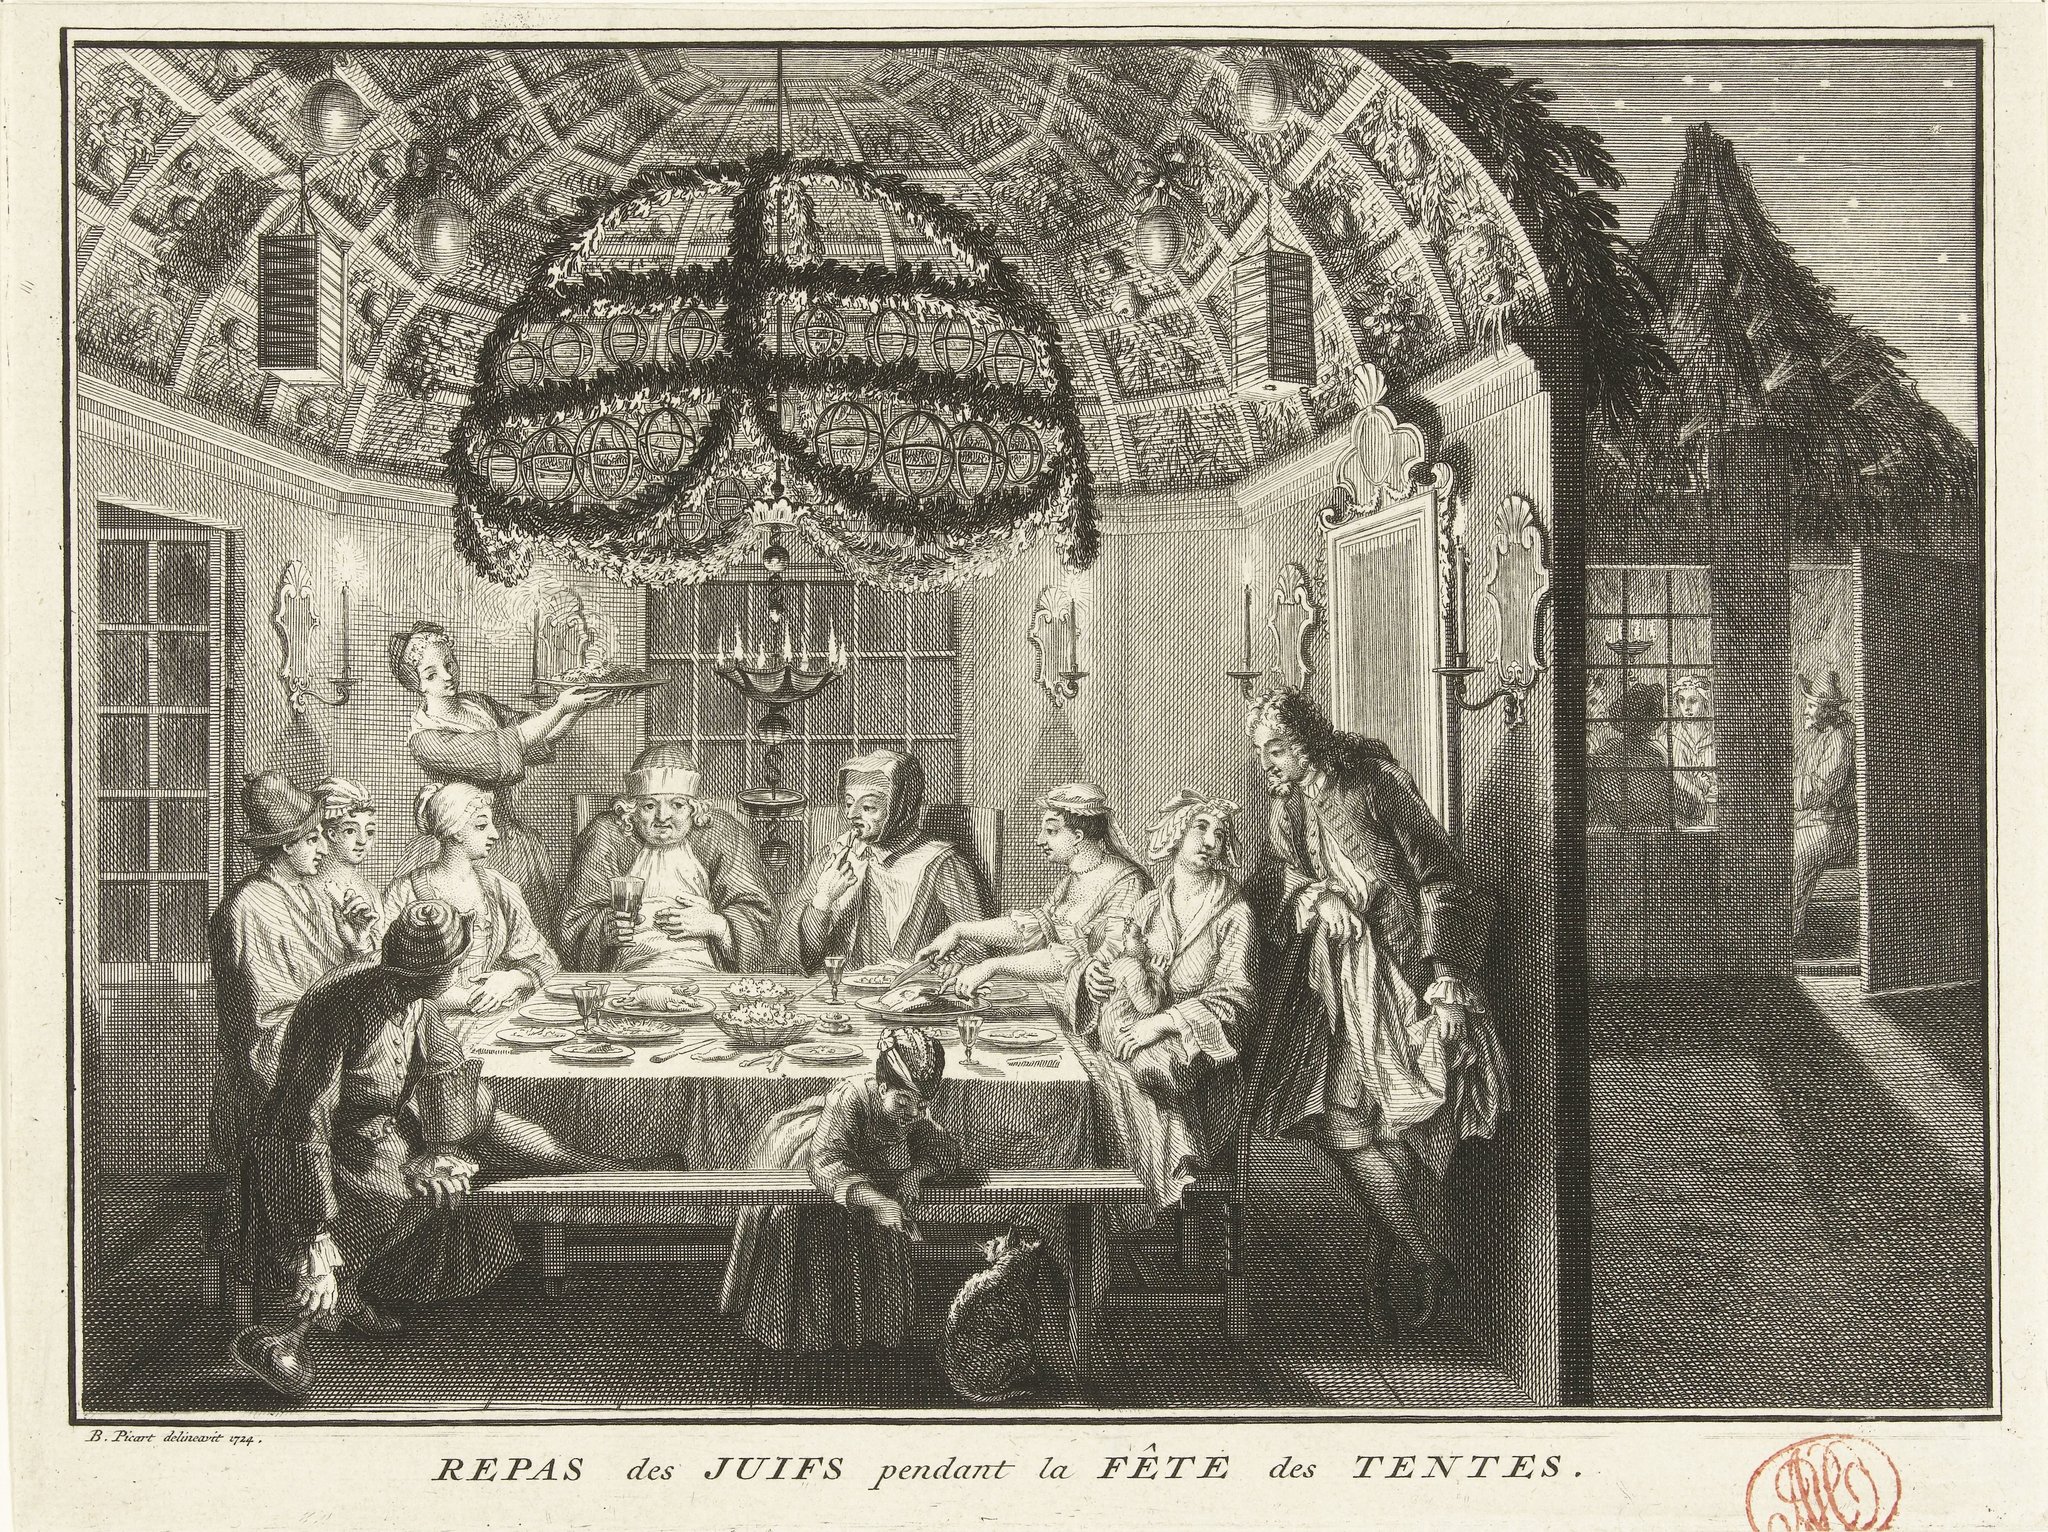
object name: print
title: Repas des Juifs pendant la Fête des Tentes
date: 1724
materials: paper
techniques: engraving, etching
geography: northern netherlands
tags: 'sukkot', feast of the tabernacles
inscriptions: collector's mark: Lugt 195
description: Gebruikt als illustratie in: A. Moubach, Naaukeurige beschryving der uitwendige godtsdienst-plichten, kerk-zeden en gewoontens van alle volkeren der waereldt : in een historisch verhaal ... in kunstige tafereelen afgemaalt. 's-Gravenhage: R.C. Alberts, 6 dln, 1727-1738. Niet in Frederik Muller; door het RPK toegevoegd nummer.